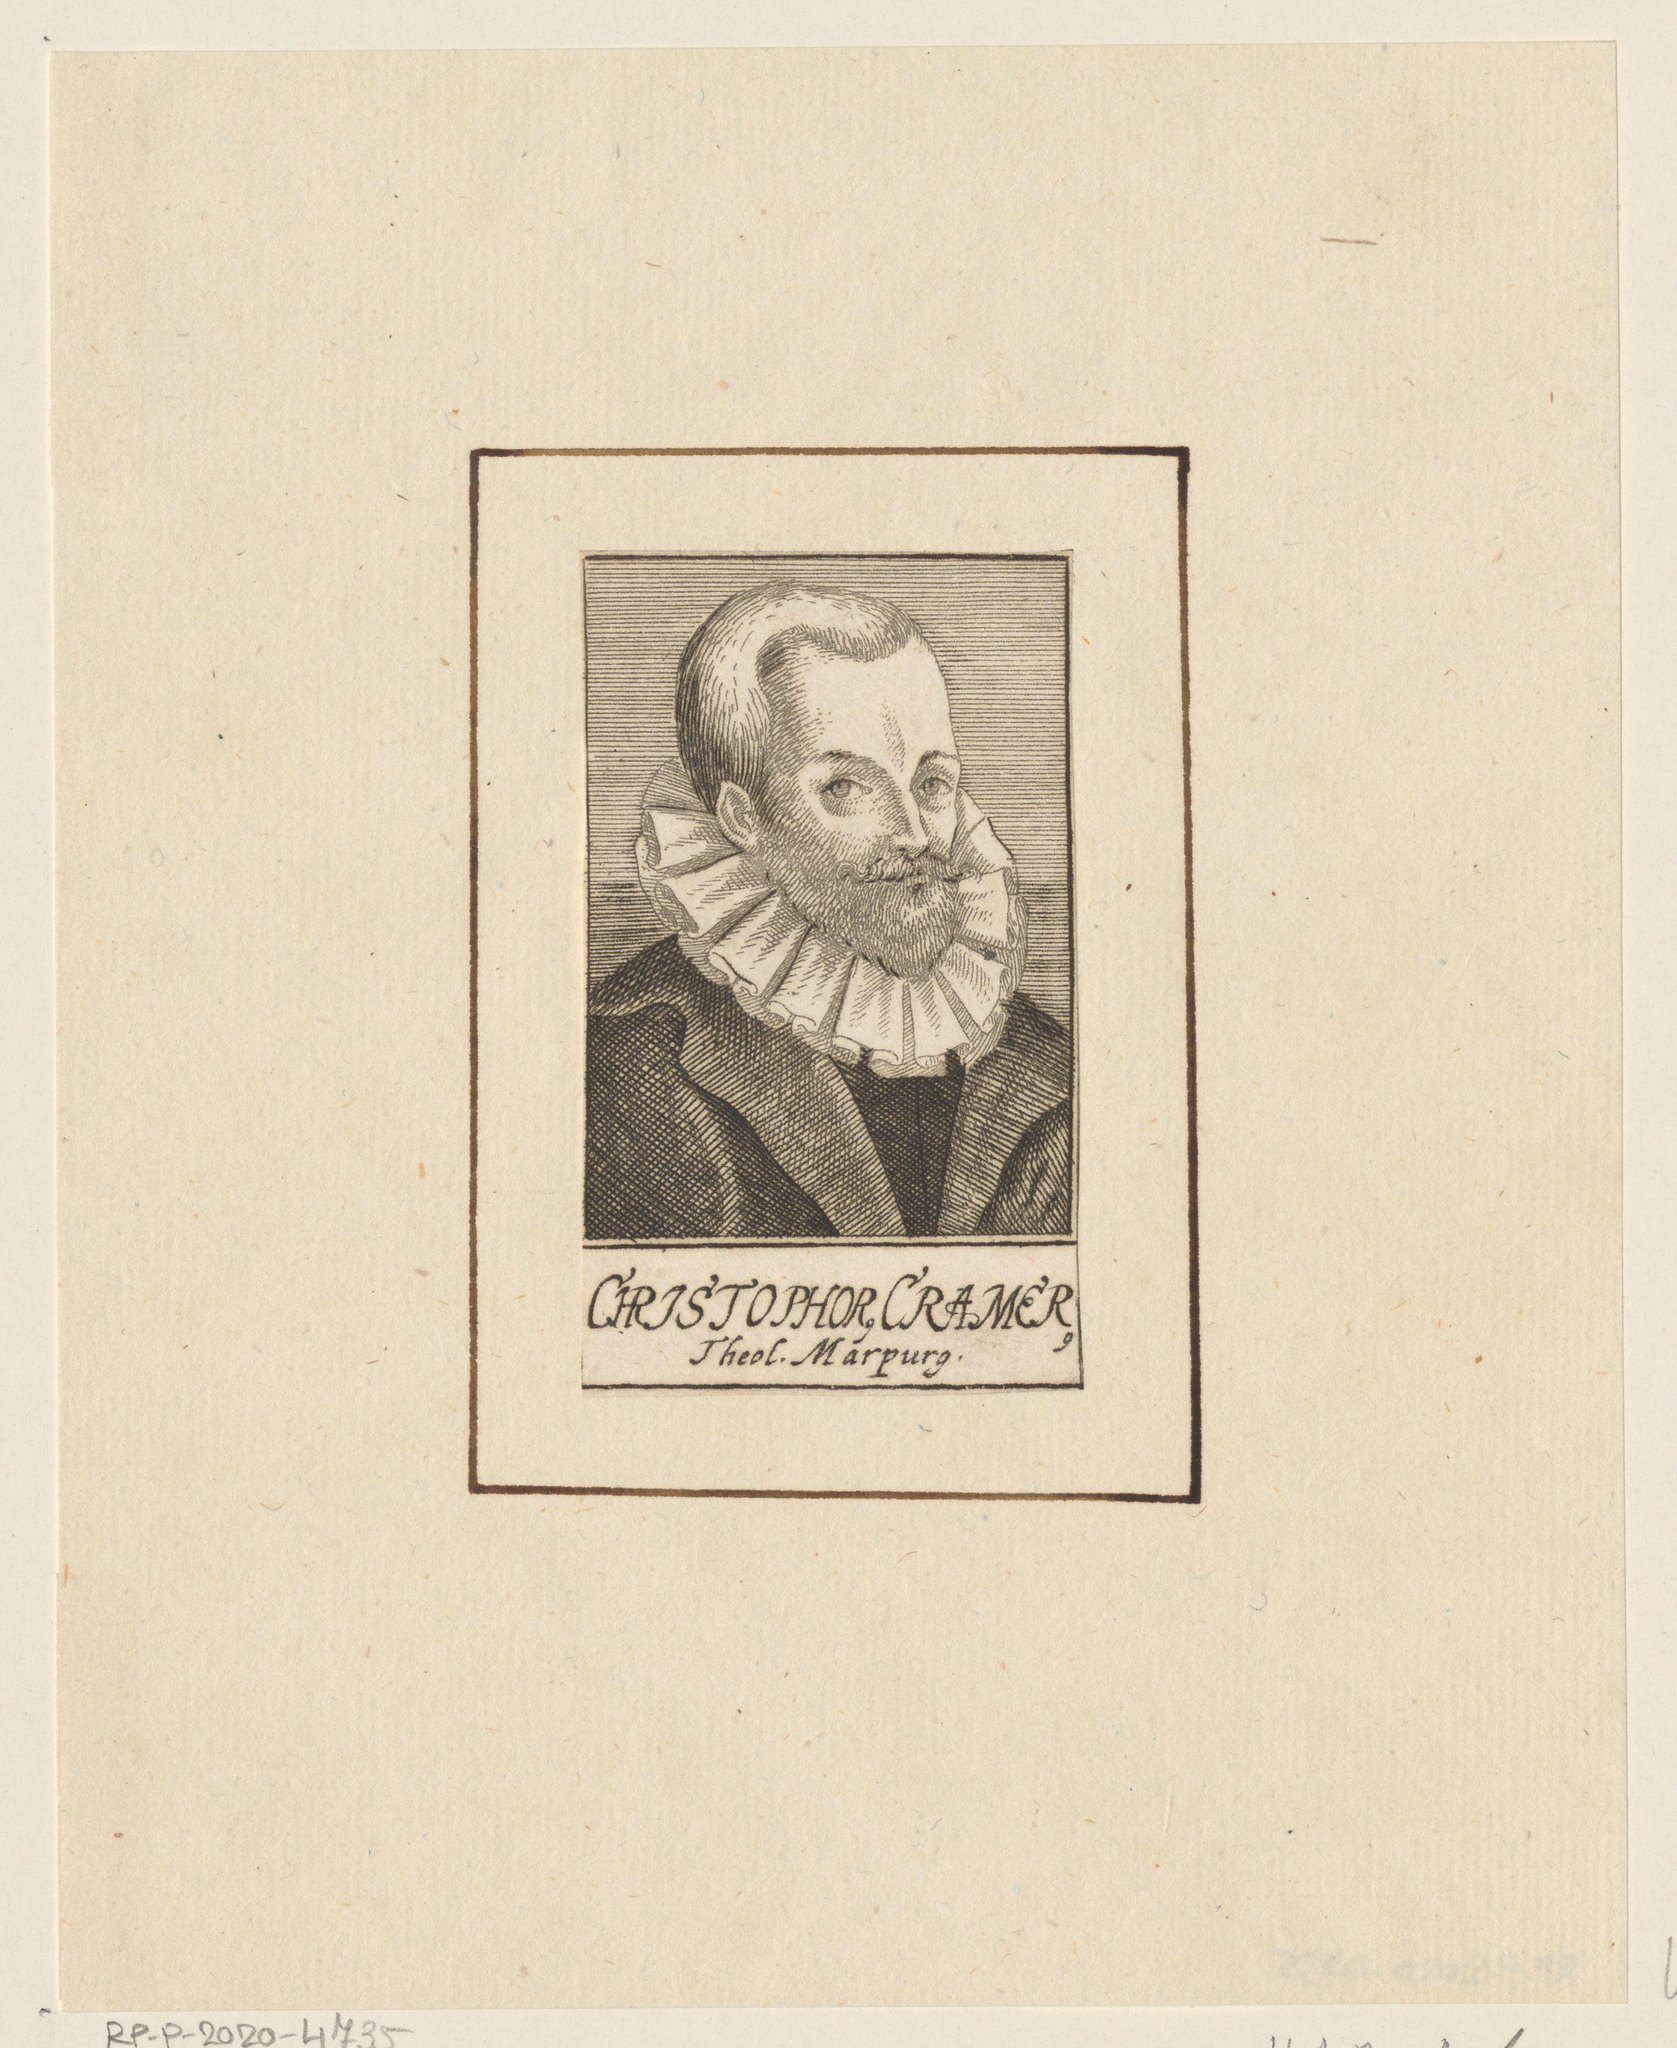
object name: print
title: Portret van Christoph Cramer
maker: Anonymous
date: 1688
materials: paper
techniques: engraving, etching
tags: theologian, historical persons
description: Prent maakt deel uit van een grotere prent die later is verknipt. Prent waarschijnlijk uit: Freher, Paul. Theatrum virorum eruditione clarorum. Neurenberg: Johann Hoffmann, 1688.